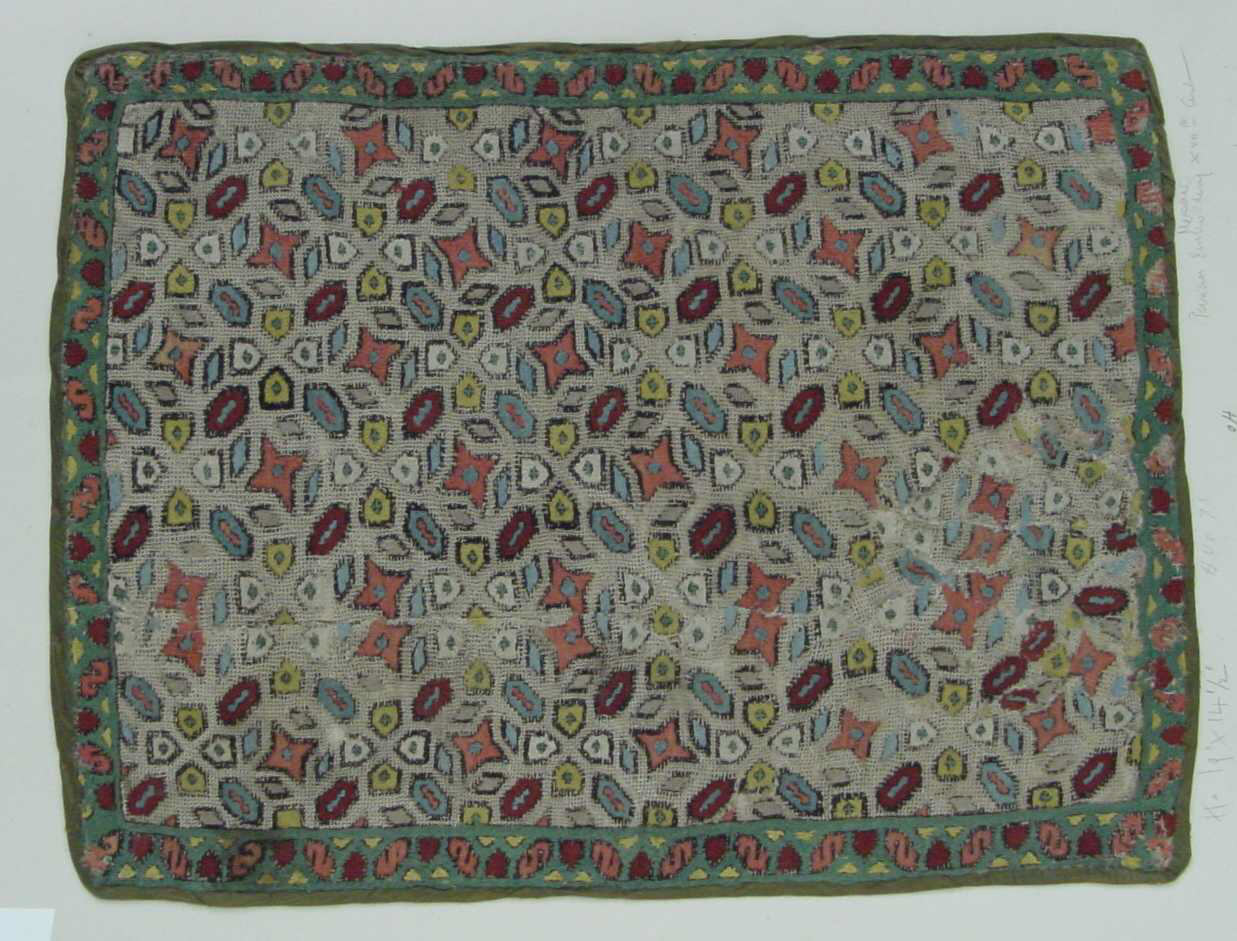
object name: textile fragment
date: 1601-1700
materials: silk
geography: iran